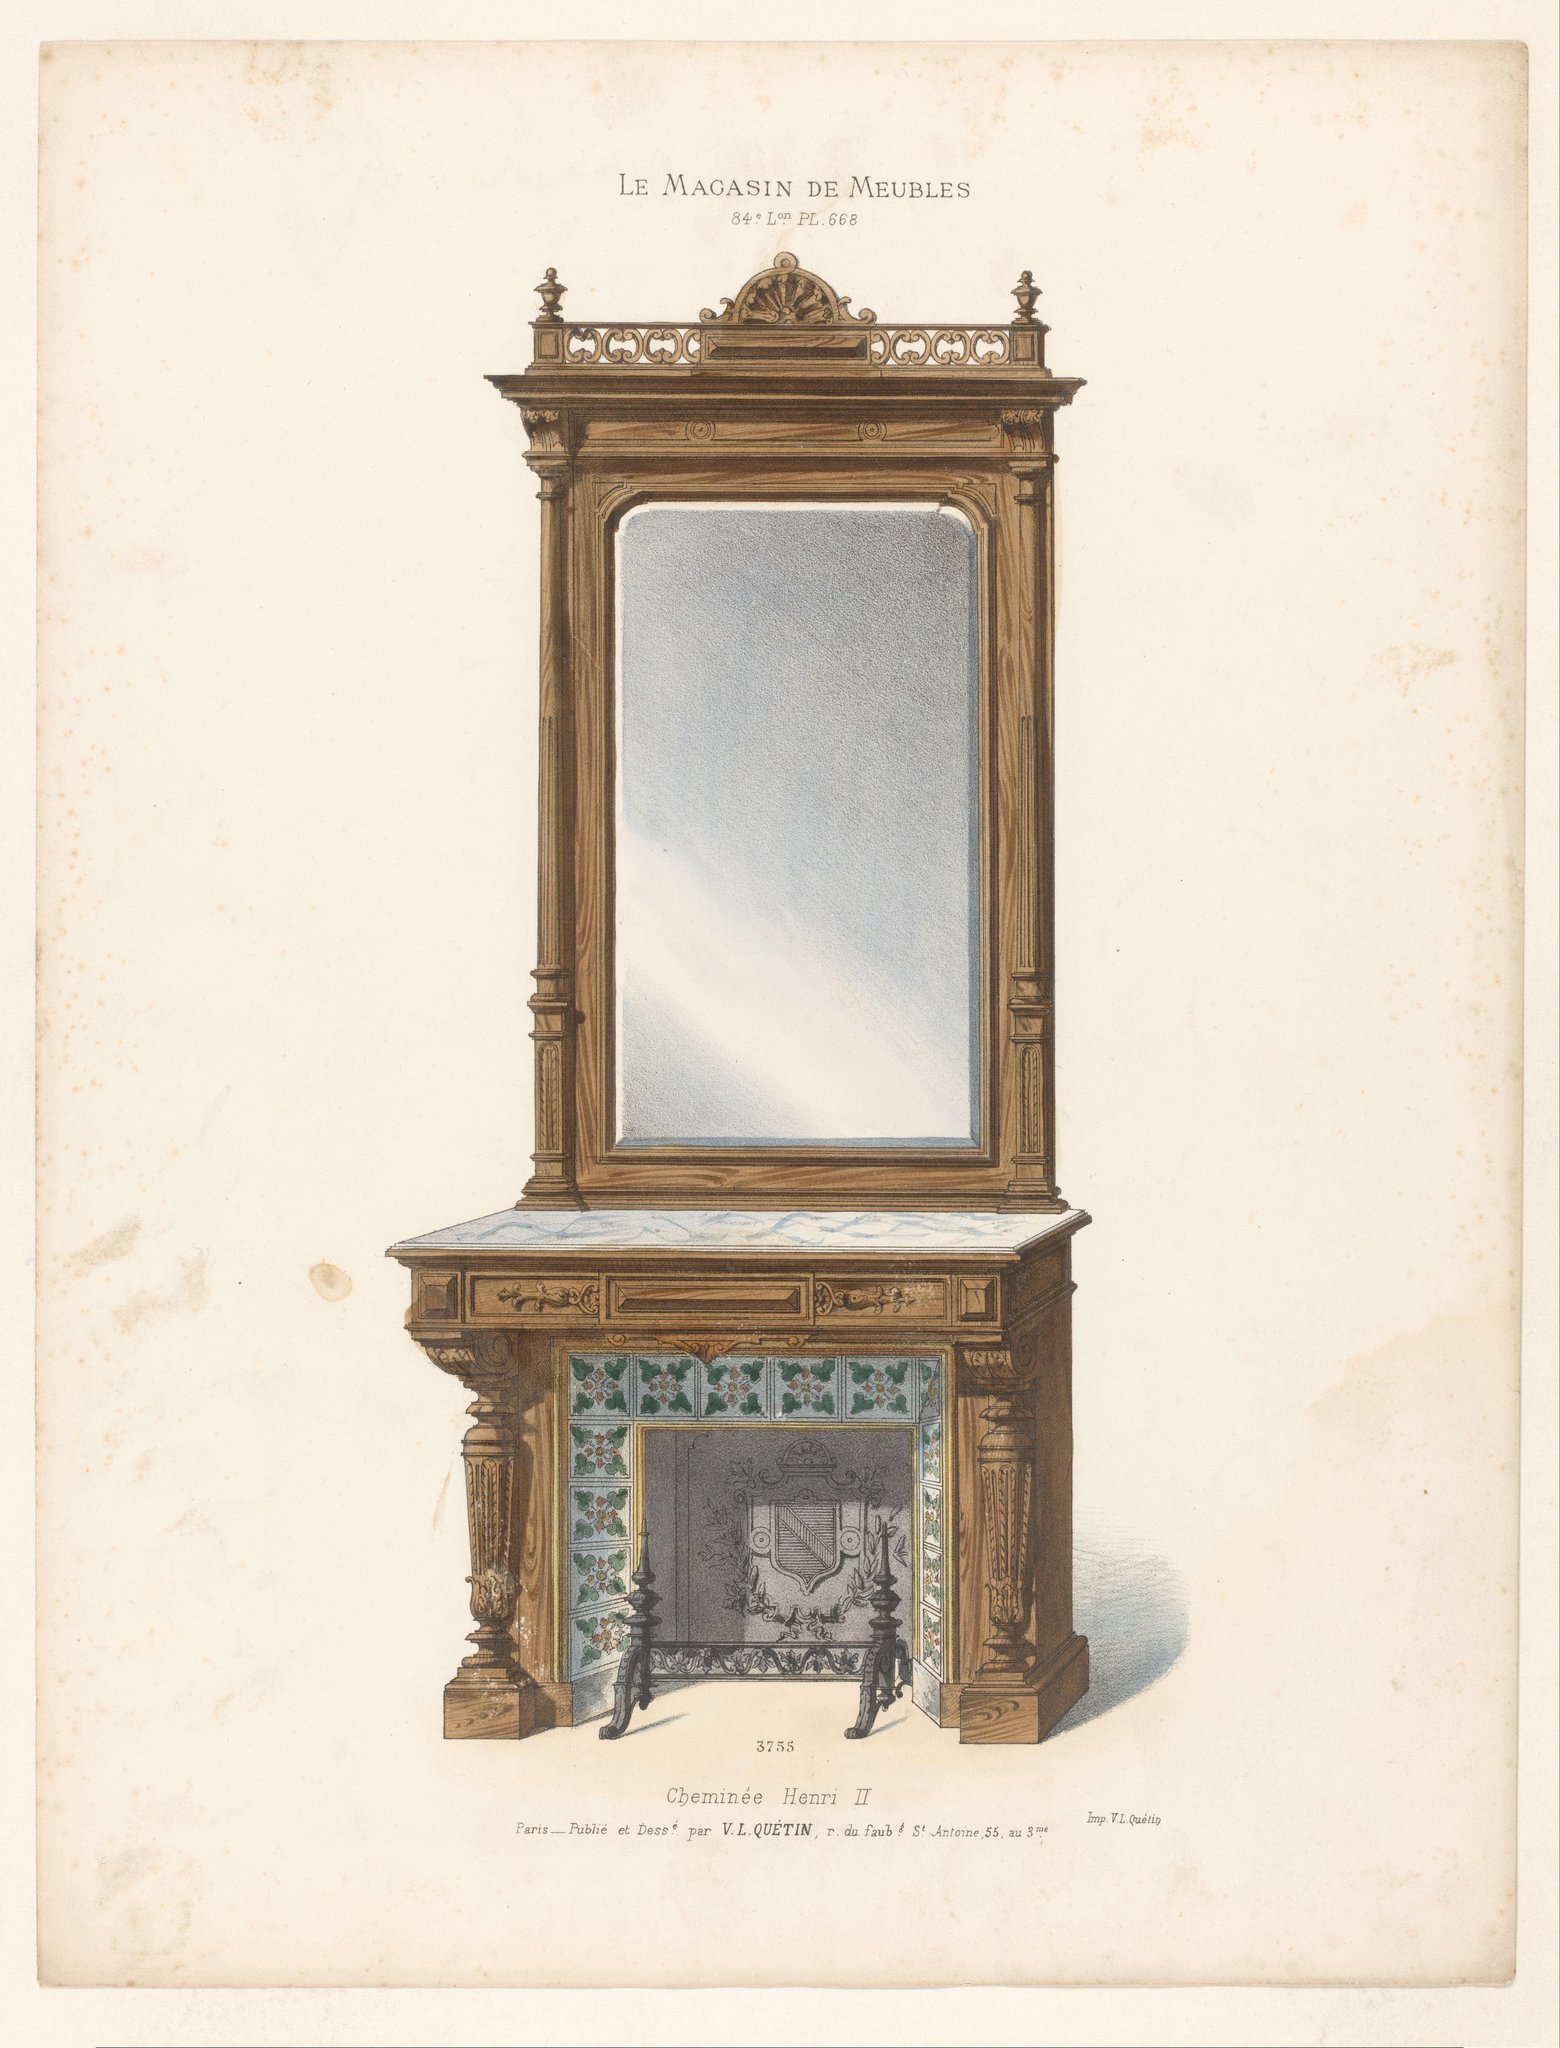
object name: print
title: Cheminée Henri II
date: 1878-1904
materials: paper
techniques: hand coloring, lithograph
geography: paris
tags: mirror, open hearth, fire-place